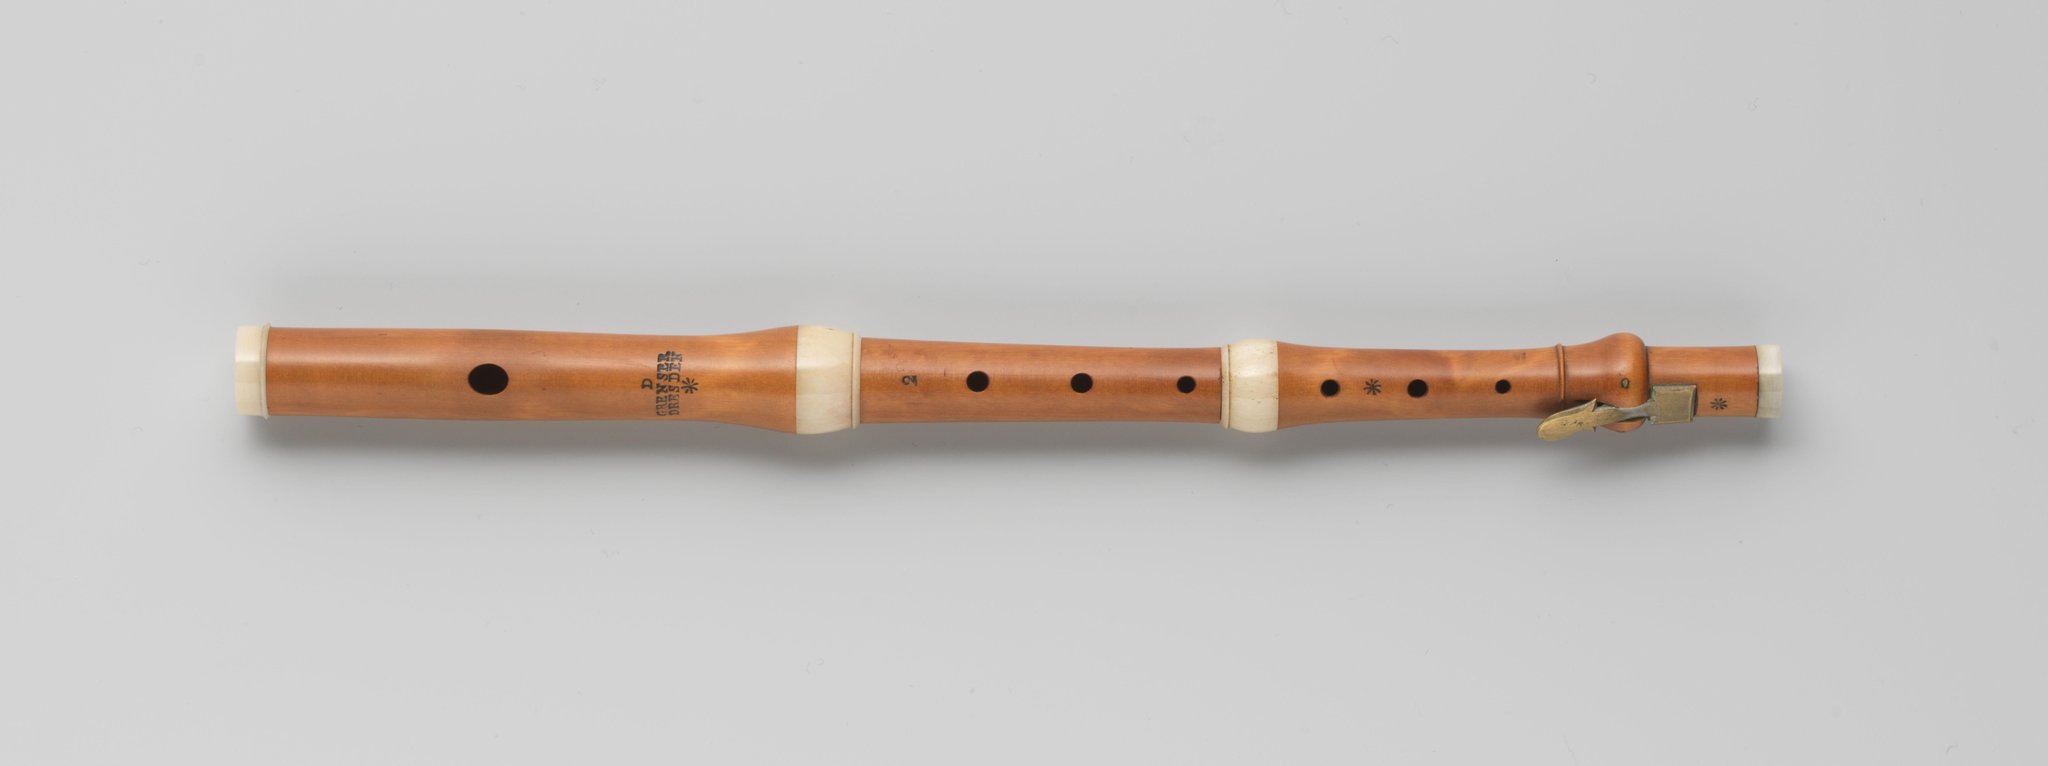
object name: flute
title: Piccolo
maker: carl august ii grenser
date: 1800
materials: wood, brass, ivory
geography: dresden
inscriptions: stamp, stamp, stamp